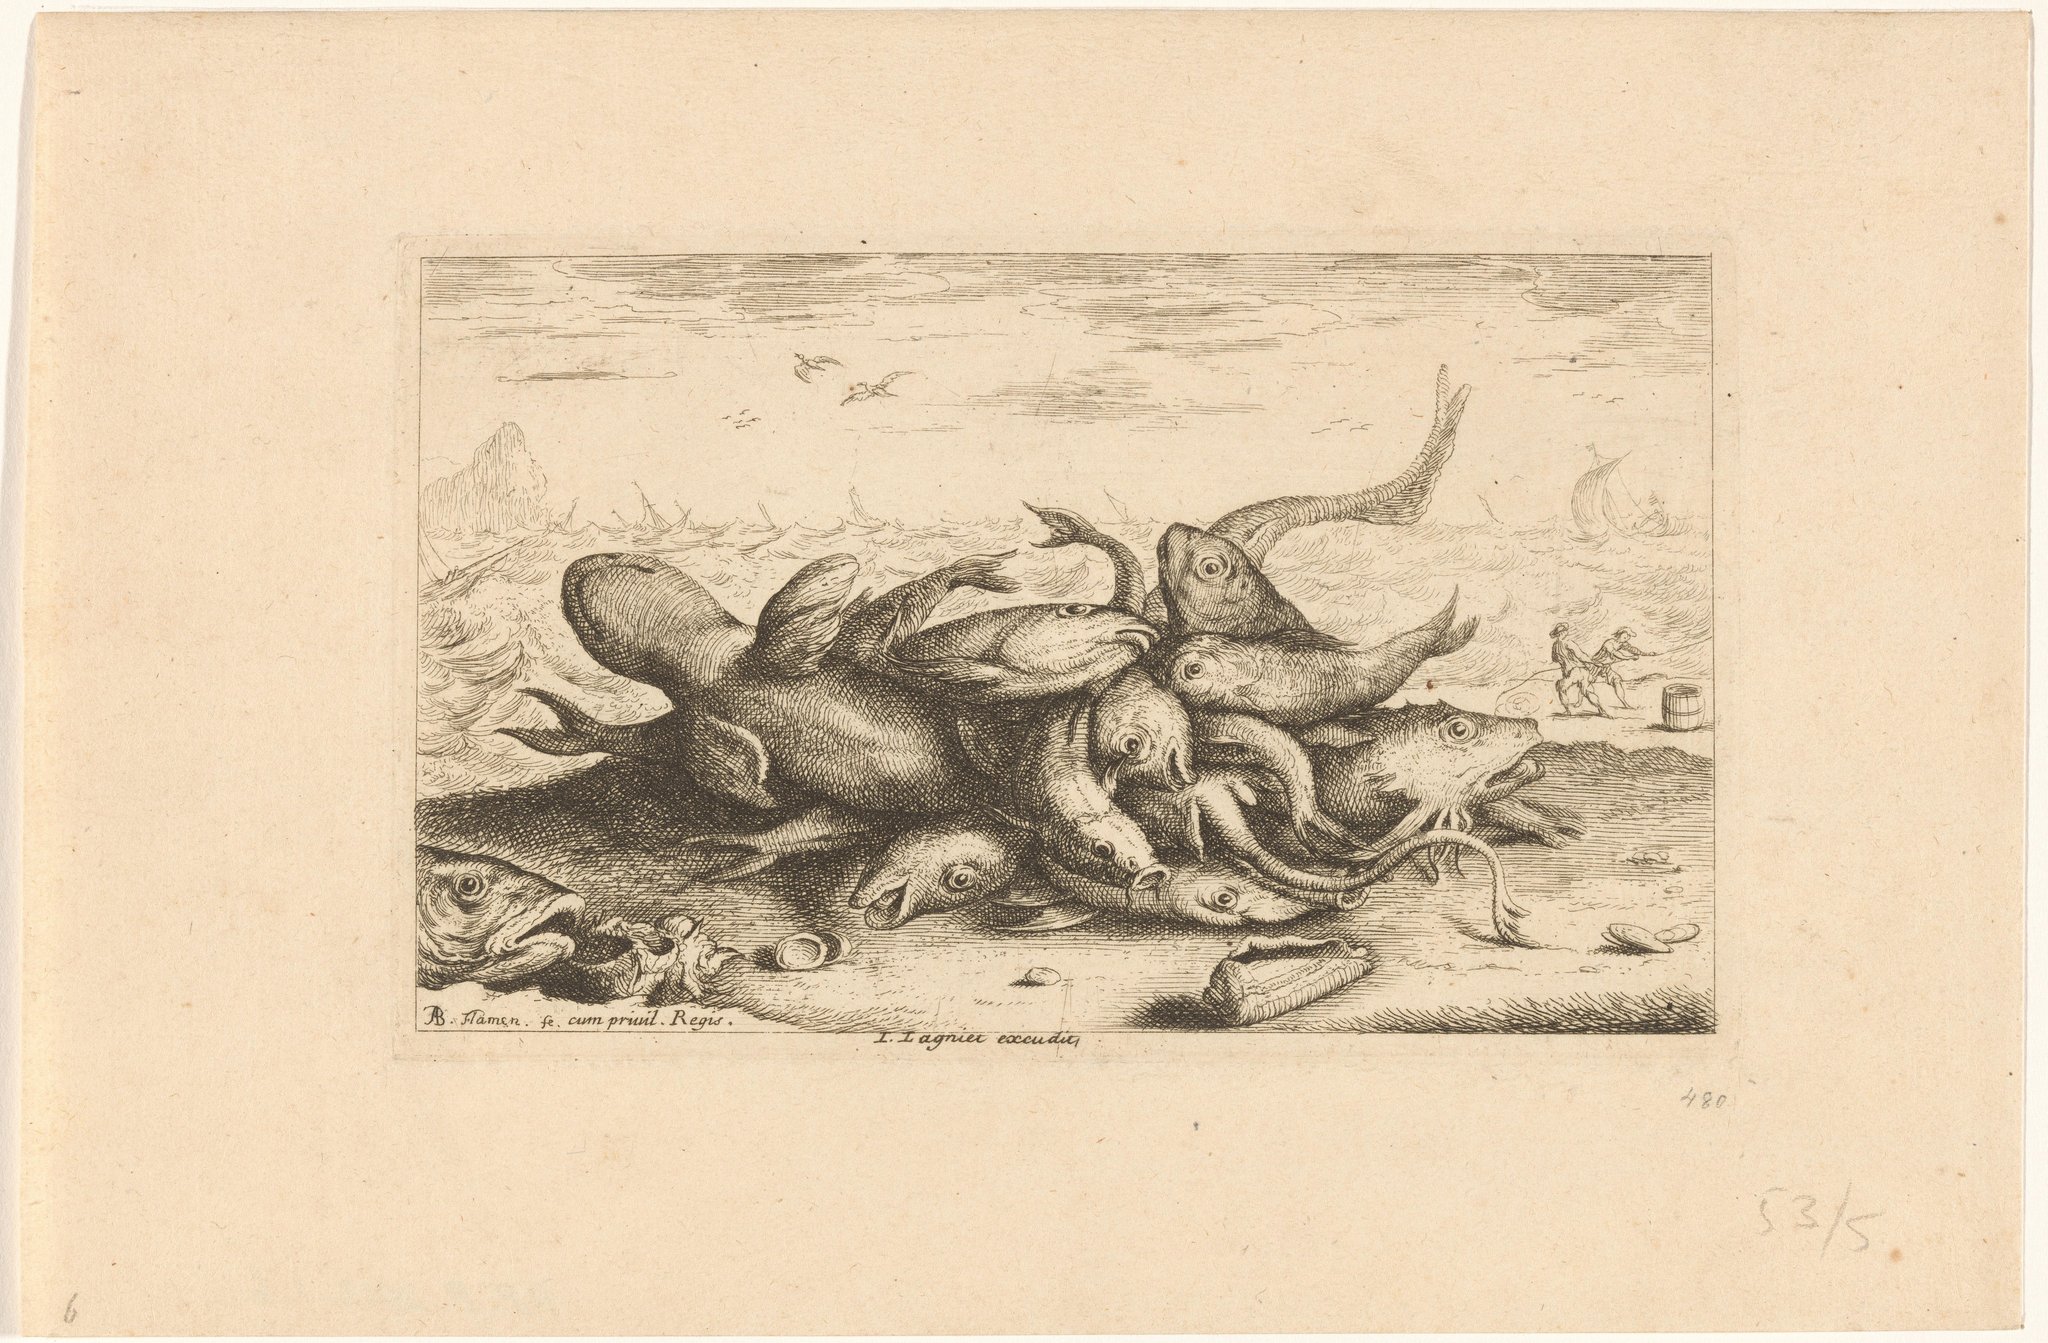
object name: print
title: Visvangst op het strand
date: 1648-1670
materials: paper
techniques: etching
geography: paris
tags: fishes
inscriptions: collector's mark: Lugt 2749, number: ‘6854/5’, number: ‘480’, number: ‘6’, number: ‘53/5’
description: Verschillende vissen op een hoop. Op de achtergrond twee personen op het strand en boten op een woelige zee.